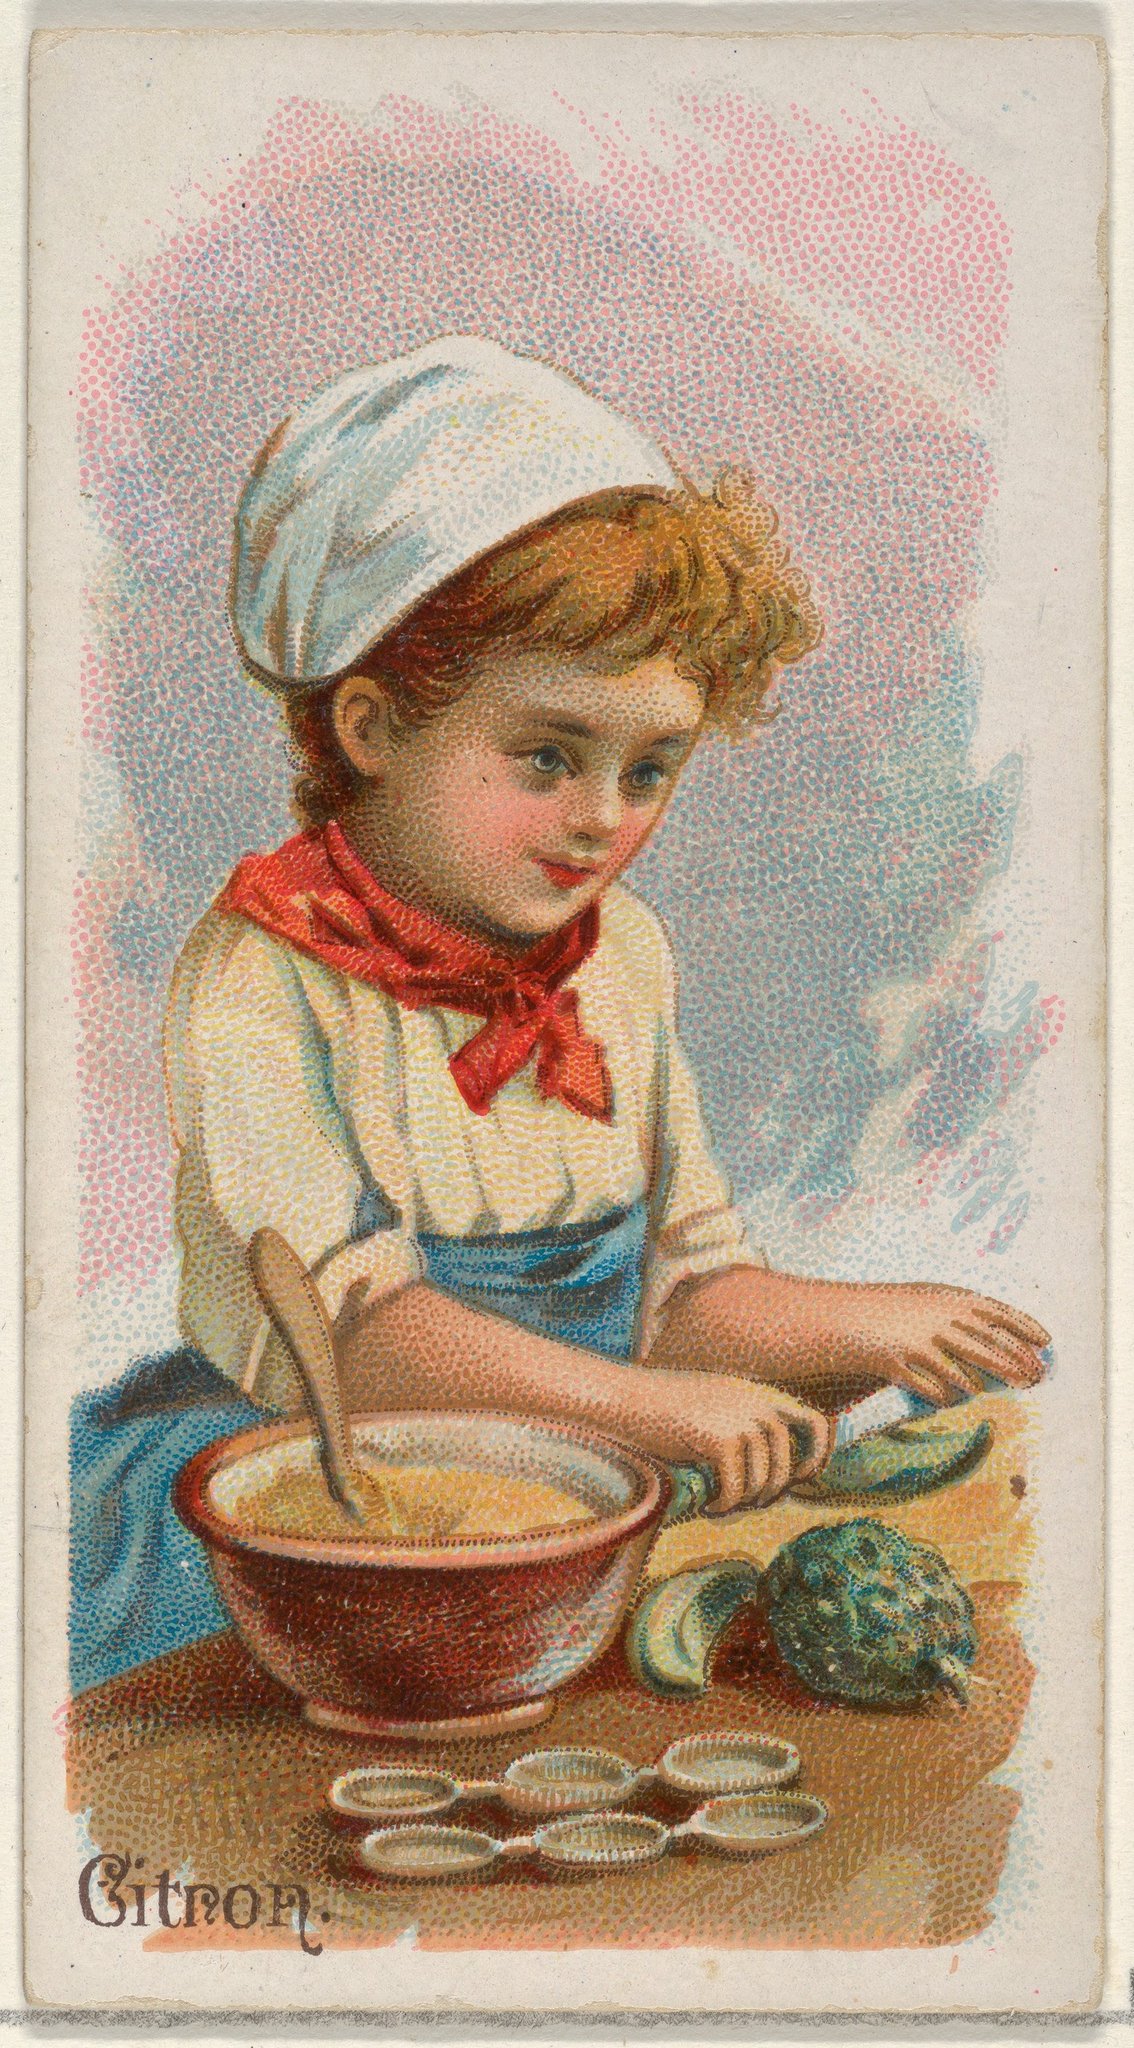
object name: print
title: Citron, from the Fruits series (N12) for Allen & Ginter Cigarettes Brands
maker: allen & ginter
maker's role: publisher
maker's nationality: american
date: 1891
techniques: color lithograph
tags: food,fruit,girls